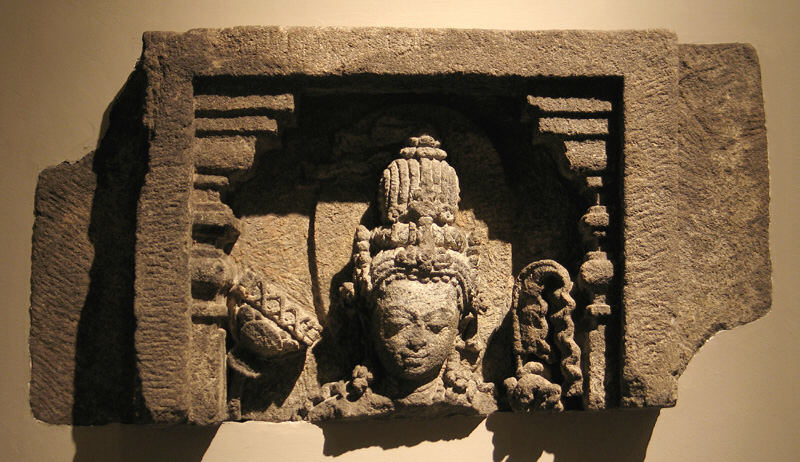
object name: relief fragment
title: Head of Manjushri, the Bodhisattva of Transcendent Wisdom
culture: indonesian, javanese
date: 801-933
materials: stone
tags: bodhisattvas,manjushri